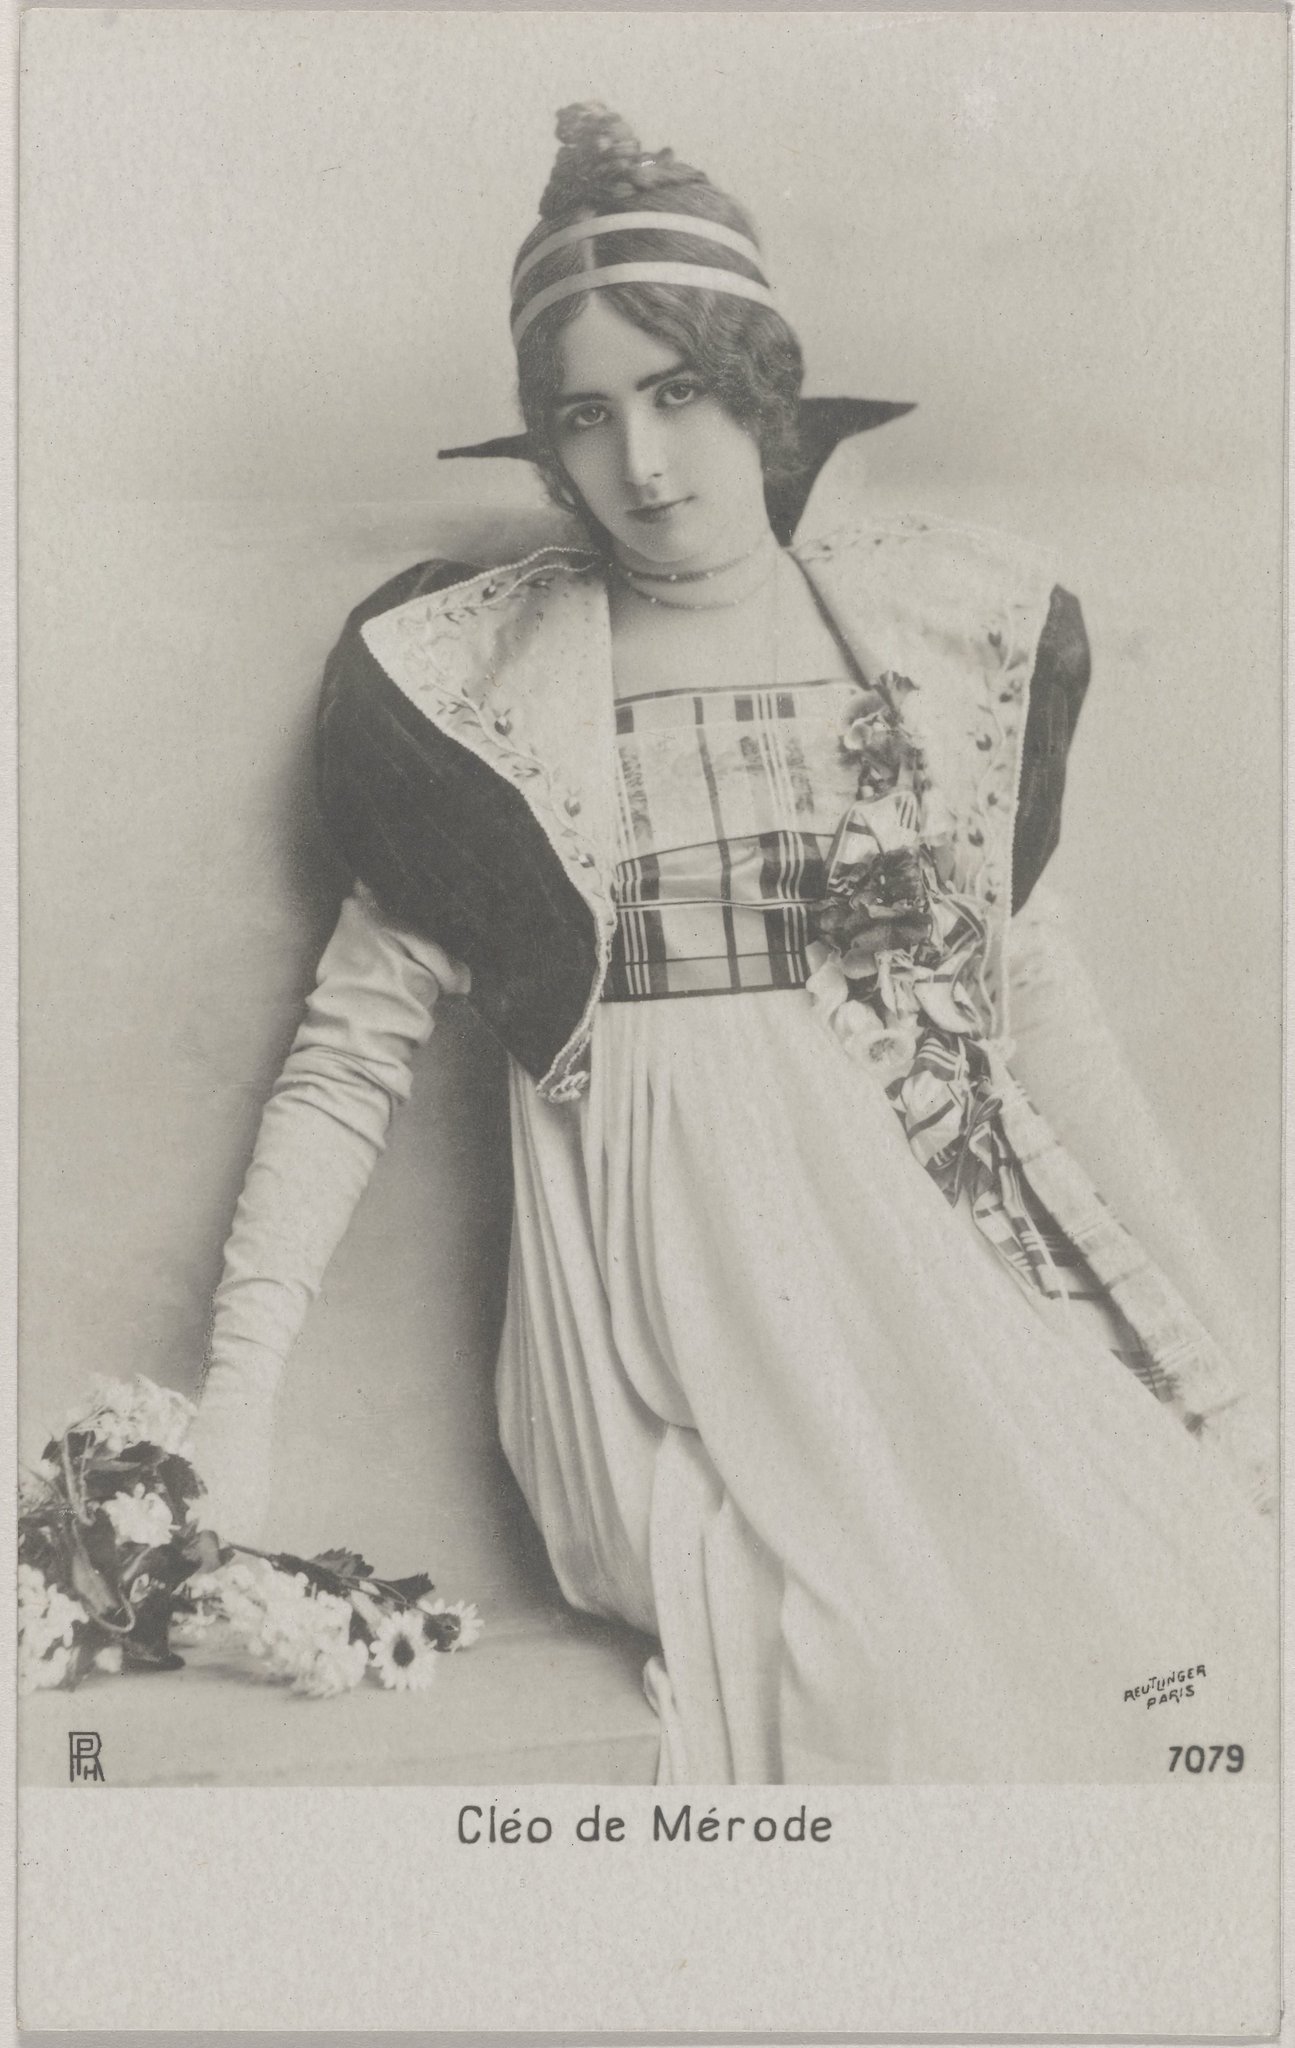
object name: photograph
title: Portret van de danseres Cléo de Mérode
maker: léopold reutlinger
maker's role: fotograaf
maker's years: 1863-1937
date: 1902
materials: paper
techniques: gelatin silver print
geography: paris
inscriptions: inscription: ‘[Monogram:] RPH, RHP, PHR, PRH, HPR of HRP / REUTLINGER / PARIS / 7079 / Cléo de Mérode’, inscription: ‘Postkarte - Carte Postale - Cartolina postale / Post card - Levelezö-Lap / Dopisnice Briefkaart / Union postale universelle Weltpostverein Unione postale universale’